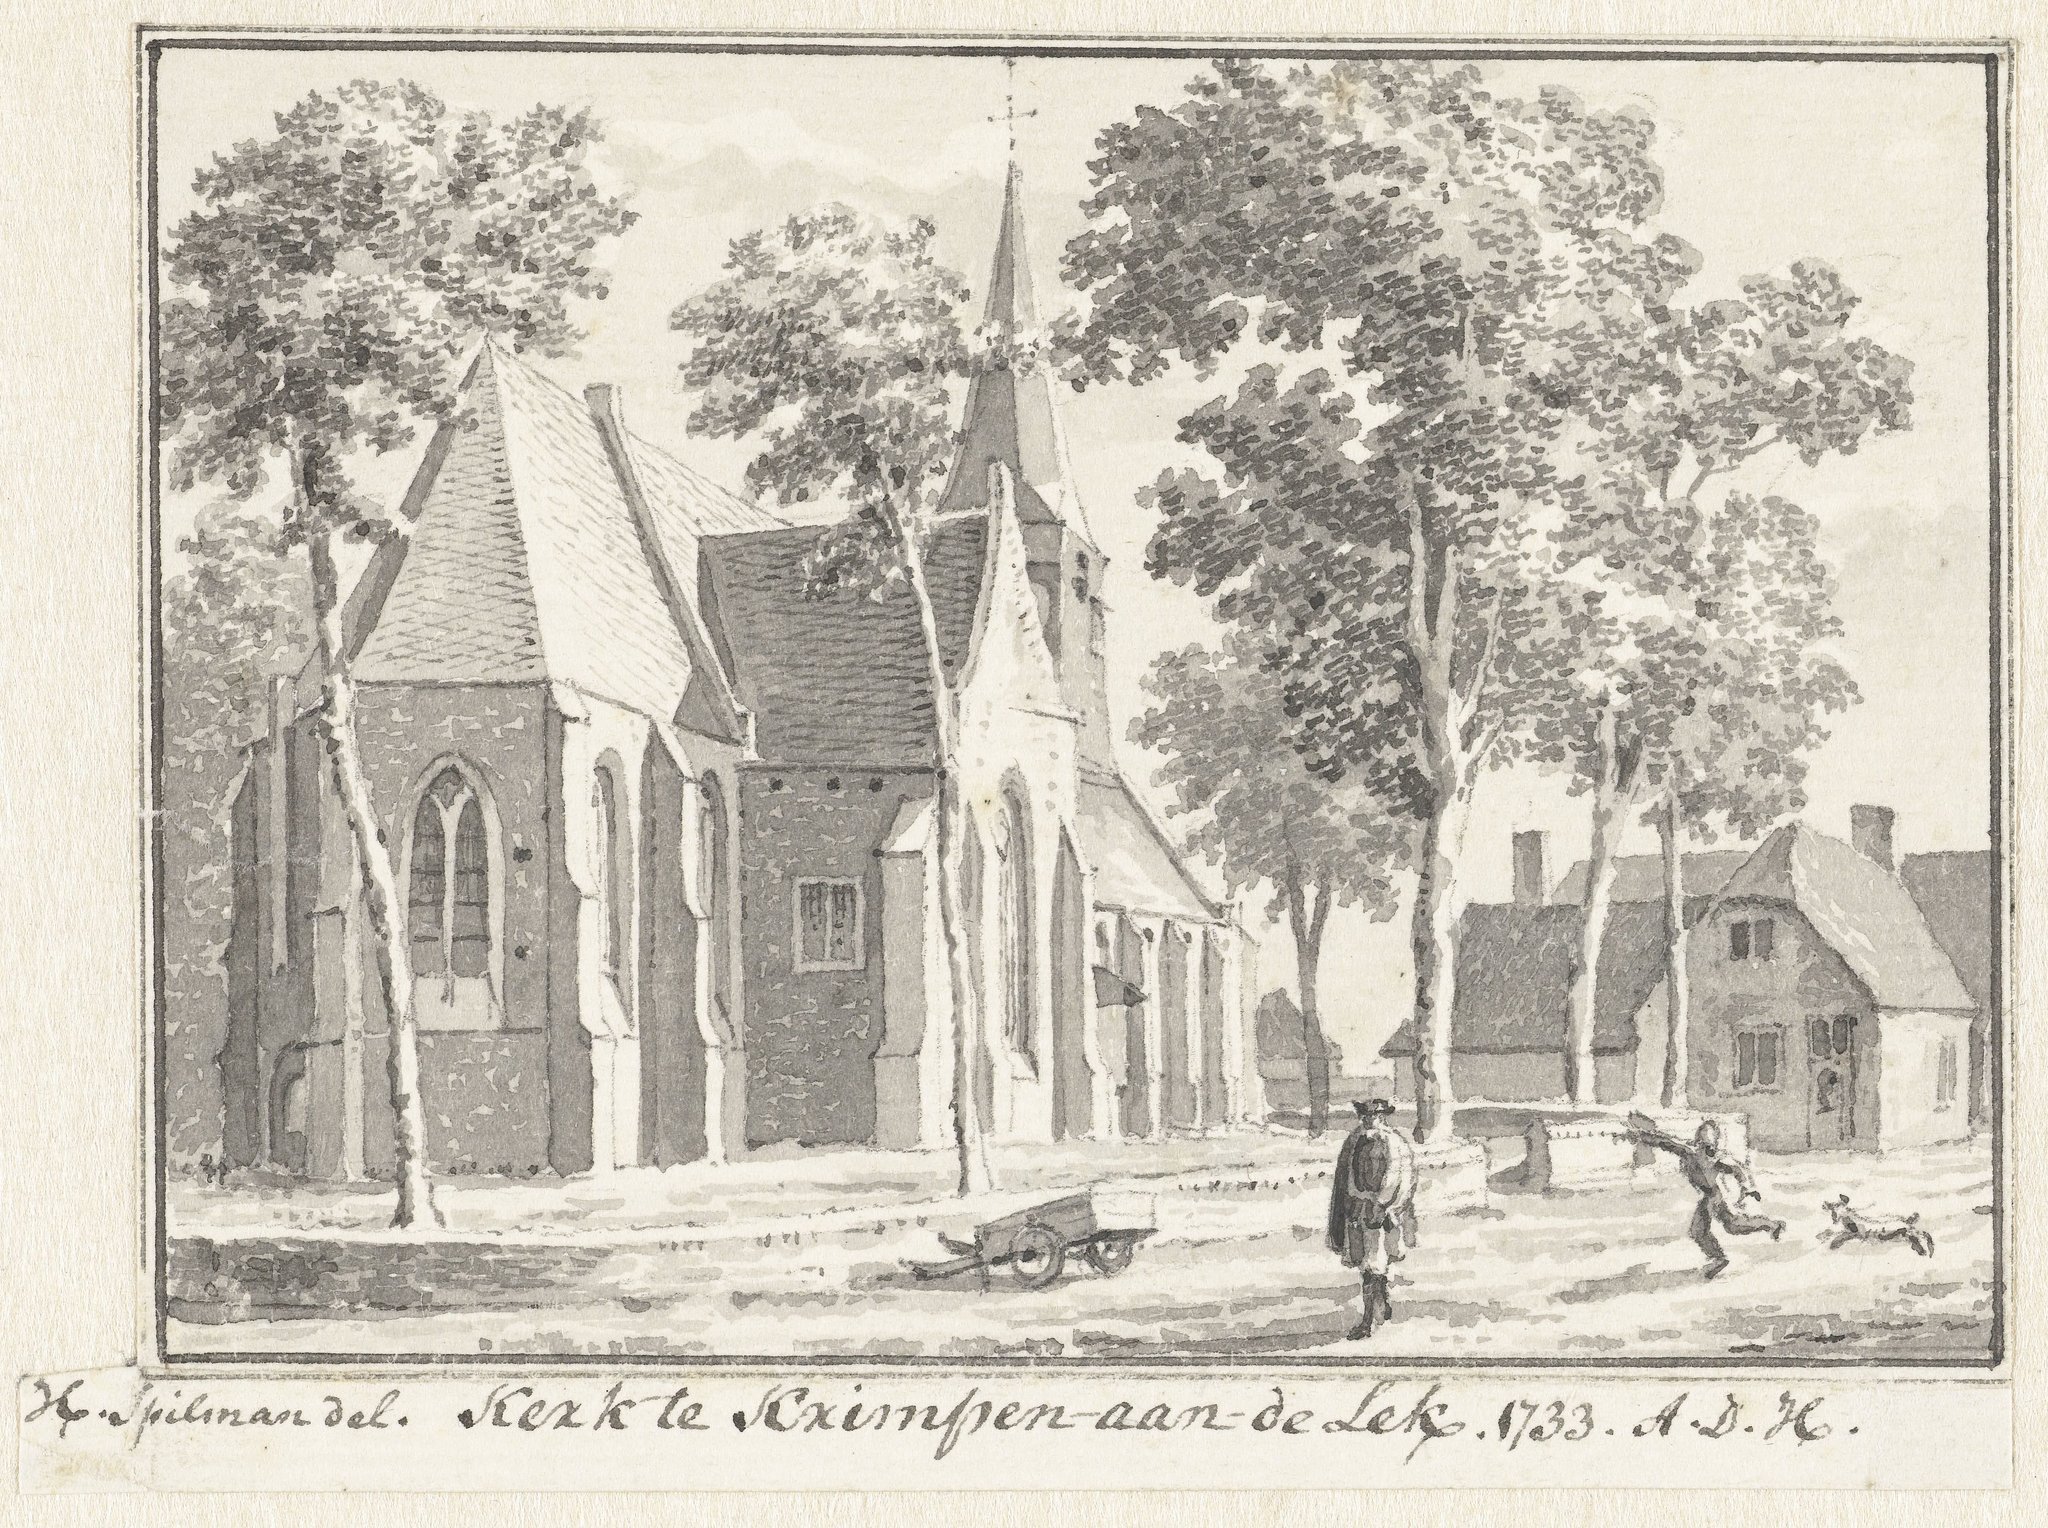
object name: drawing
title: De kerk in het dorp Krimpen aan de Lek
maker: hendrik spilman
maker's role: draughtsman, painter, print maker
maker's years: 1721-1784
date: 1733-1784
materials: ink, paper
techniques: brush, pen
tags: prospect of village, silhouette of village, church (exterior)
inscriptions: inscription: ‘H. Spilman. del. Kerk te Krimpen aan de Lek. 1733. A.D.H.’